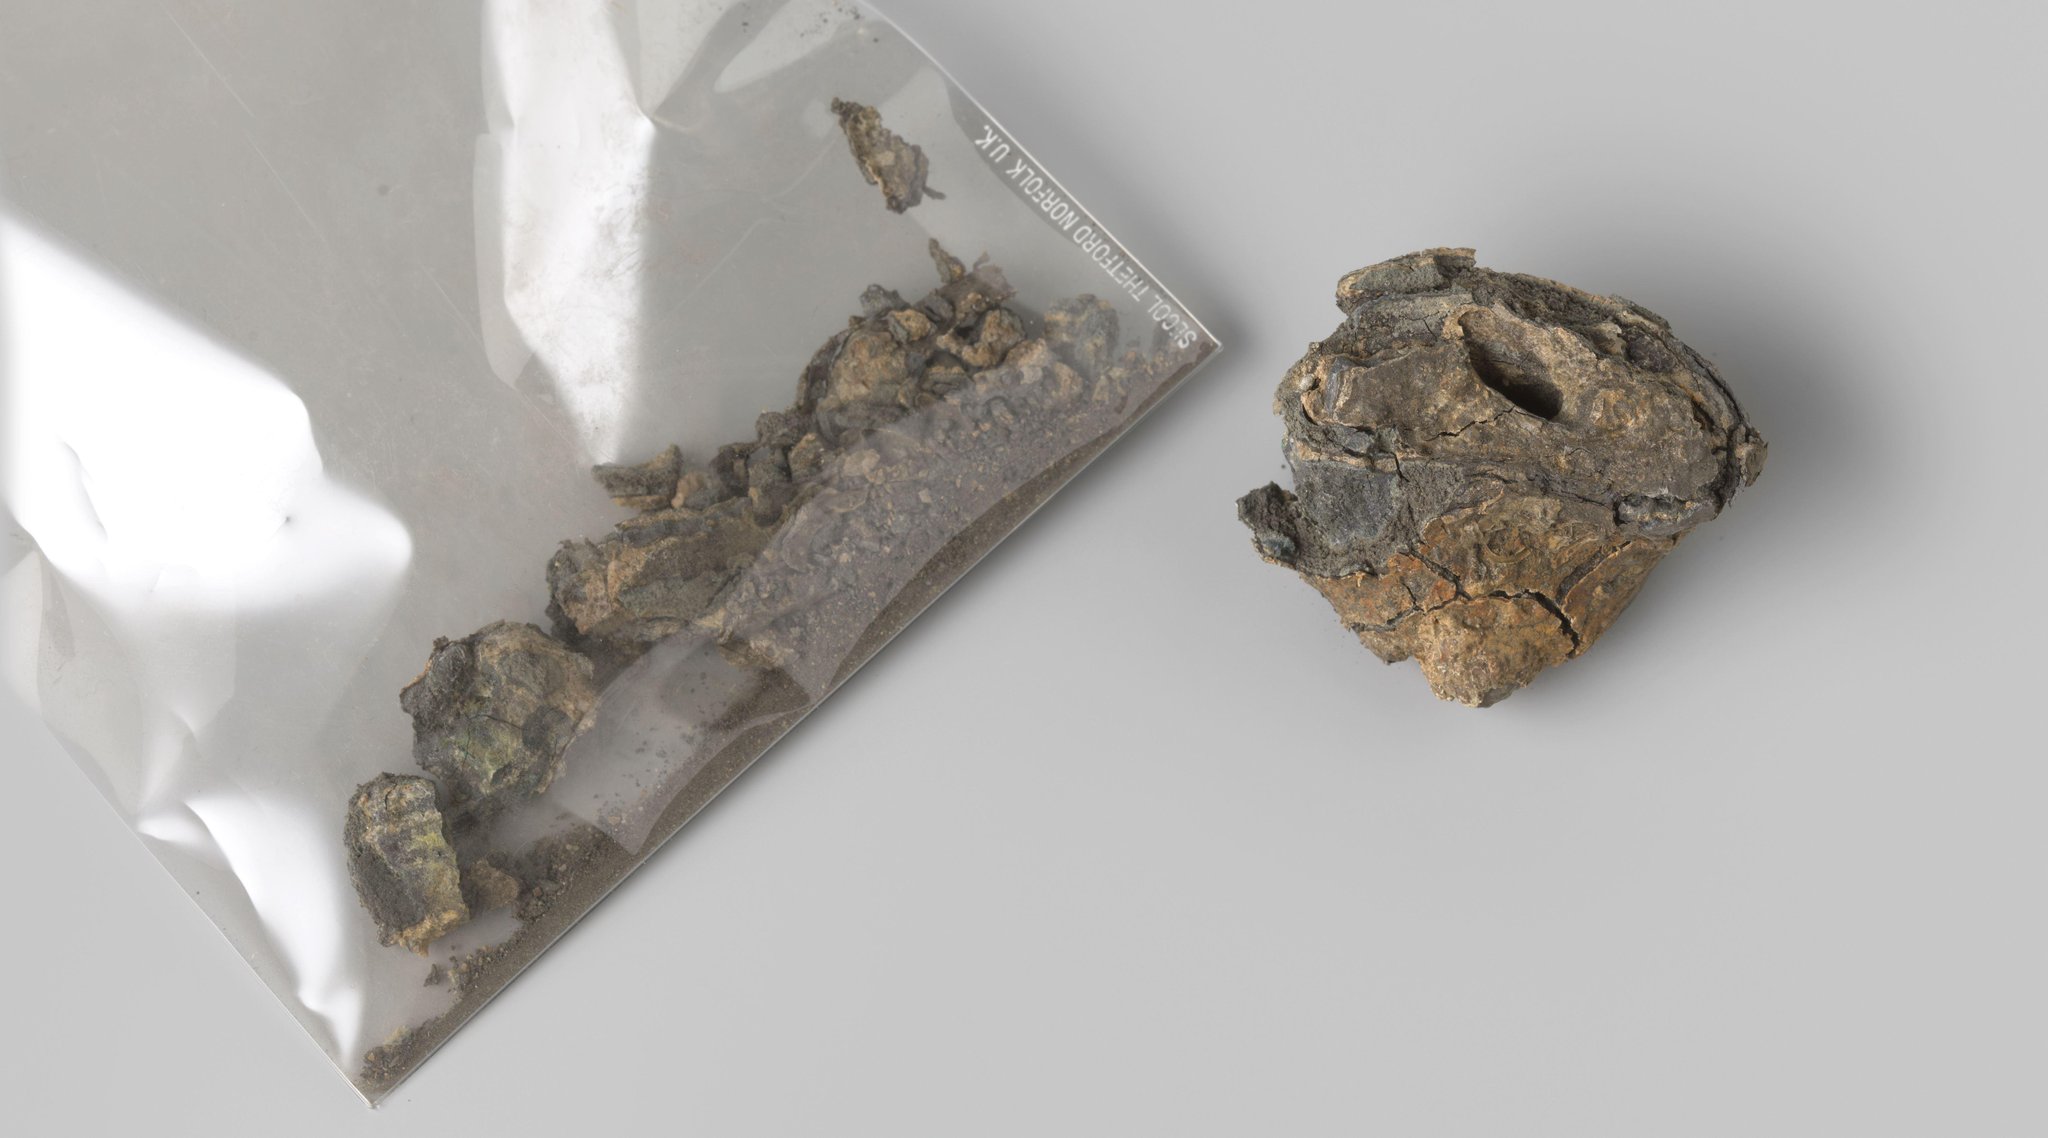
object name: verpakking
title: Fragmenten schroefdop uit het wrak van de Oost-Indiëvaarder Hollandia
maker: Anonymous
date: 1700-1743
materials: tin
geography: netherlands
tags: verenigde oostindische compagnie, hollandia (schip), annet